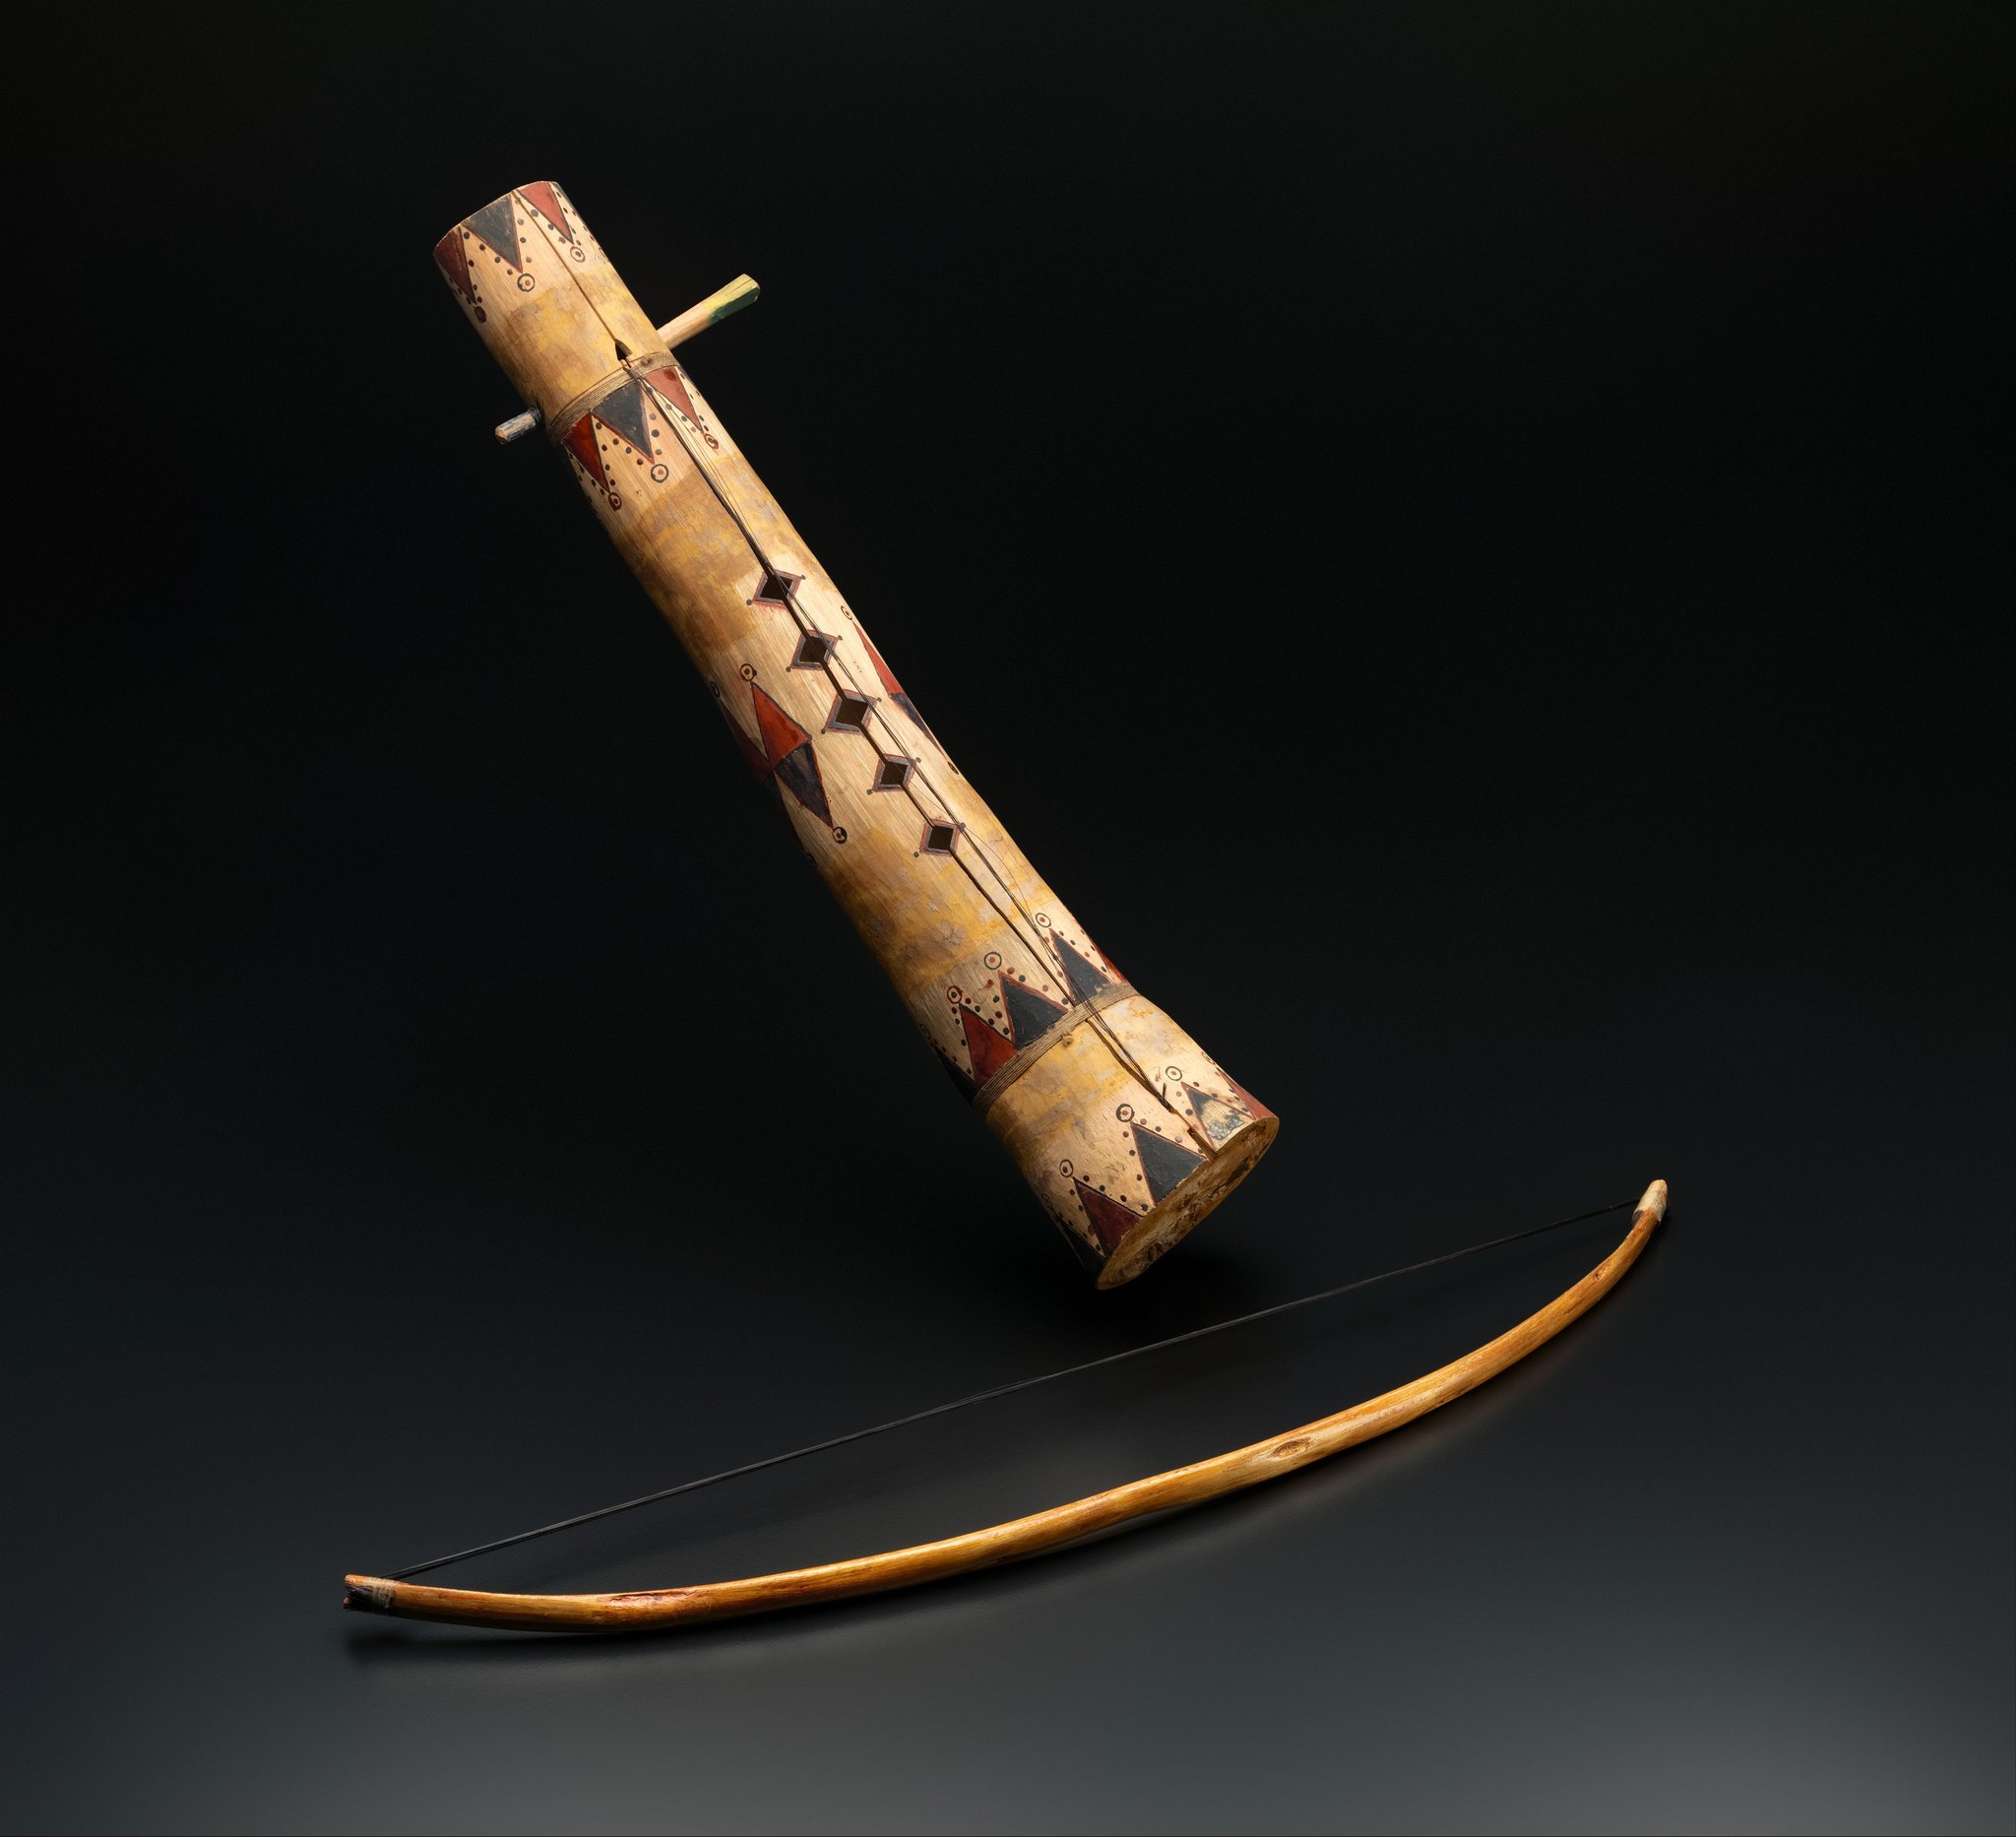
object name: tsii 'edo' a'tl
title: Tsii' Edo' Ai (Apache fiddle)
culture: native american, apache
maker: athabascan family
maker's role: maker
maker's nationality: native american (apache)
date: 1900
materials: hair, paint, wood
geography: united states